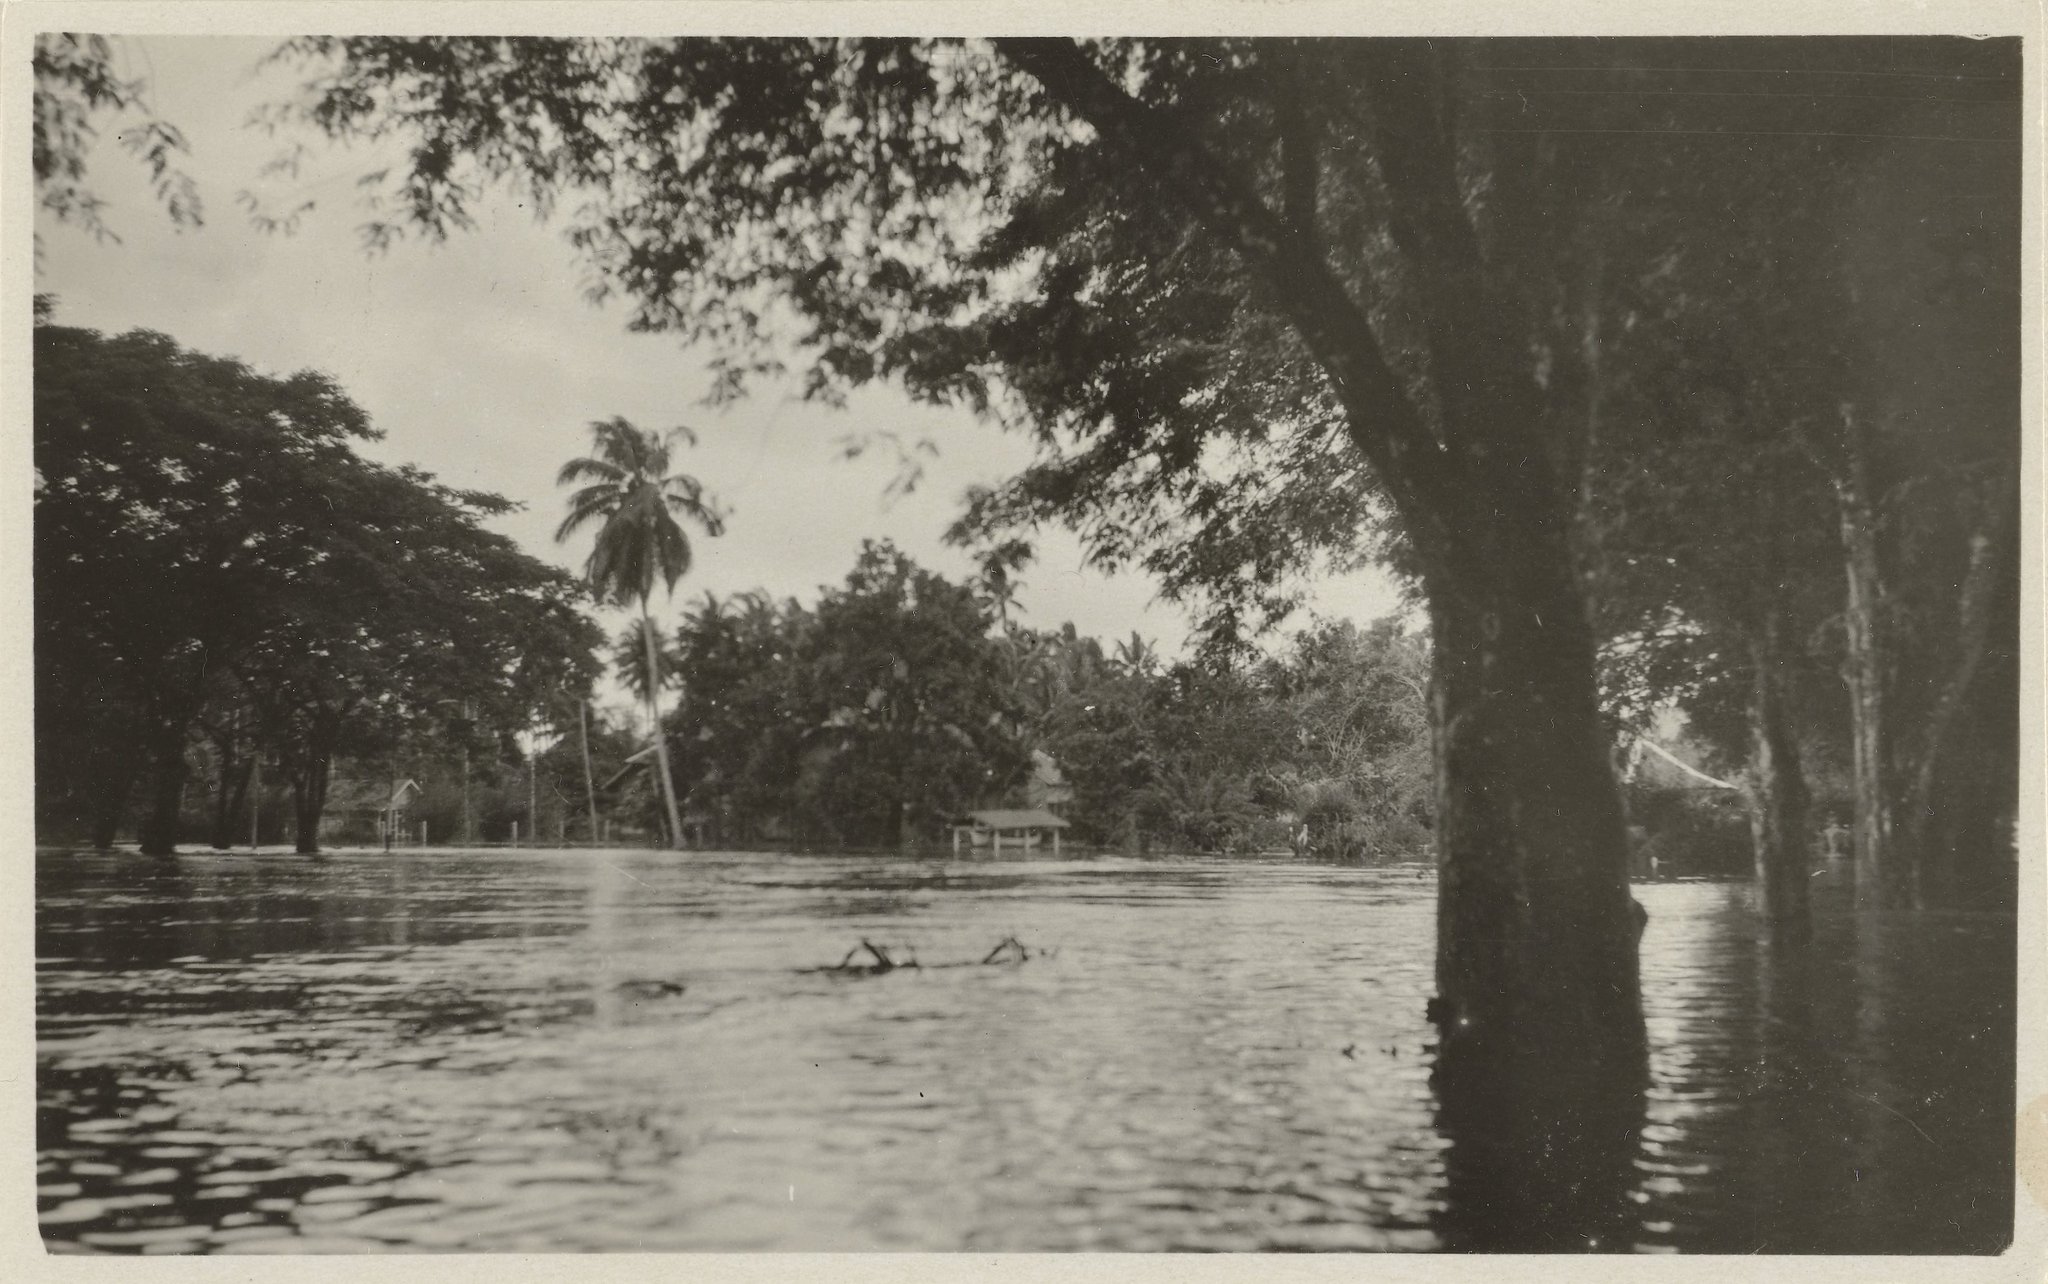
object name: photograph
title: Onderwater gelopen straat in Singkawang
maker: Anonymous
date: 1920-1940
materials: photographic support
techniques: gelatin silver print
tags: borneo